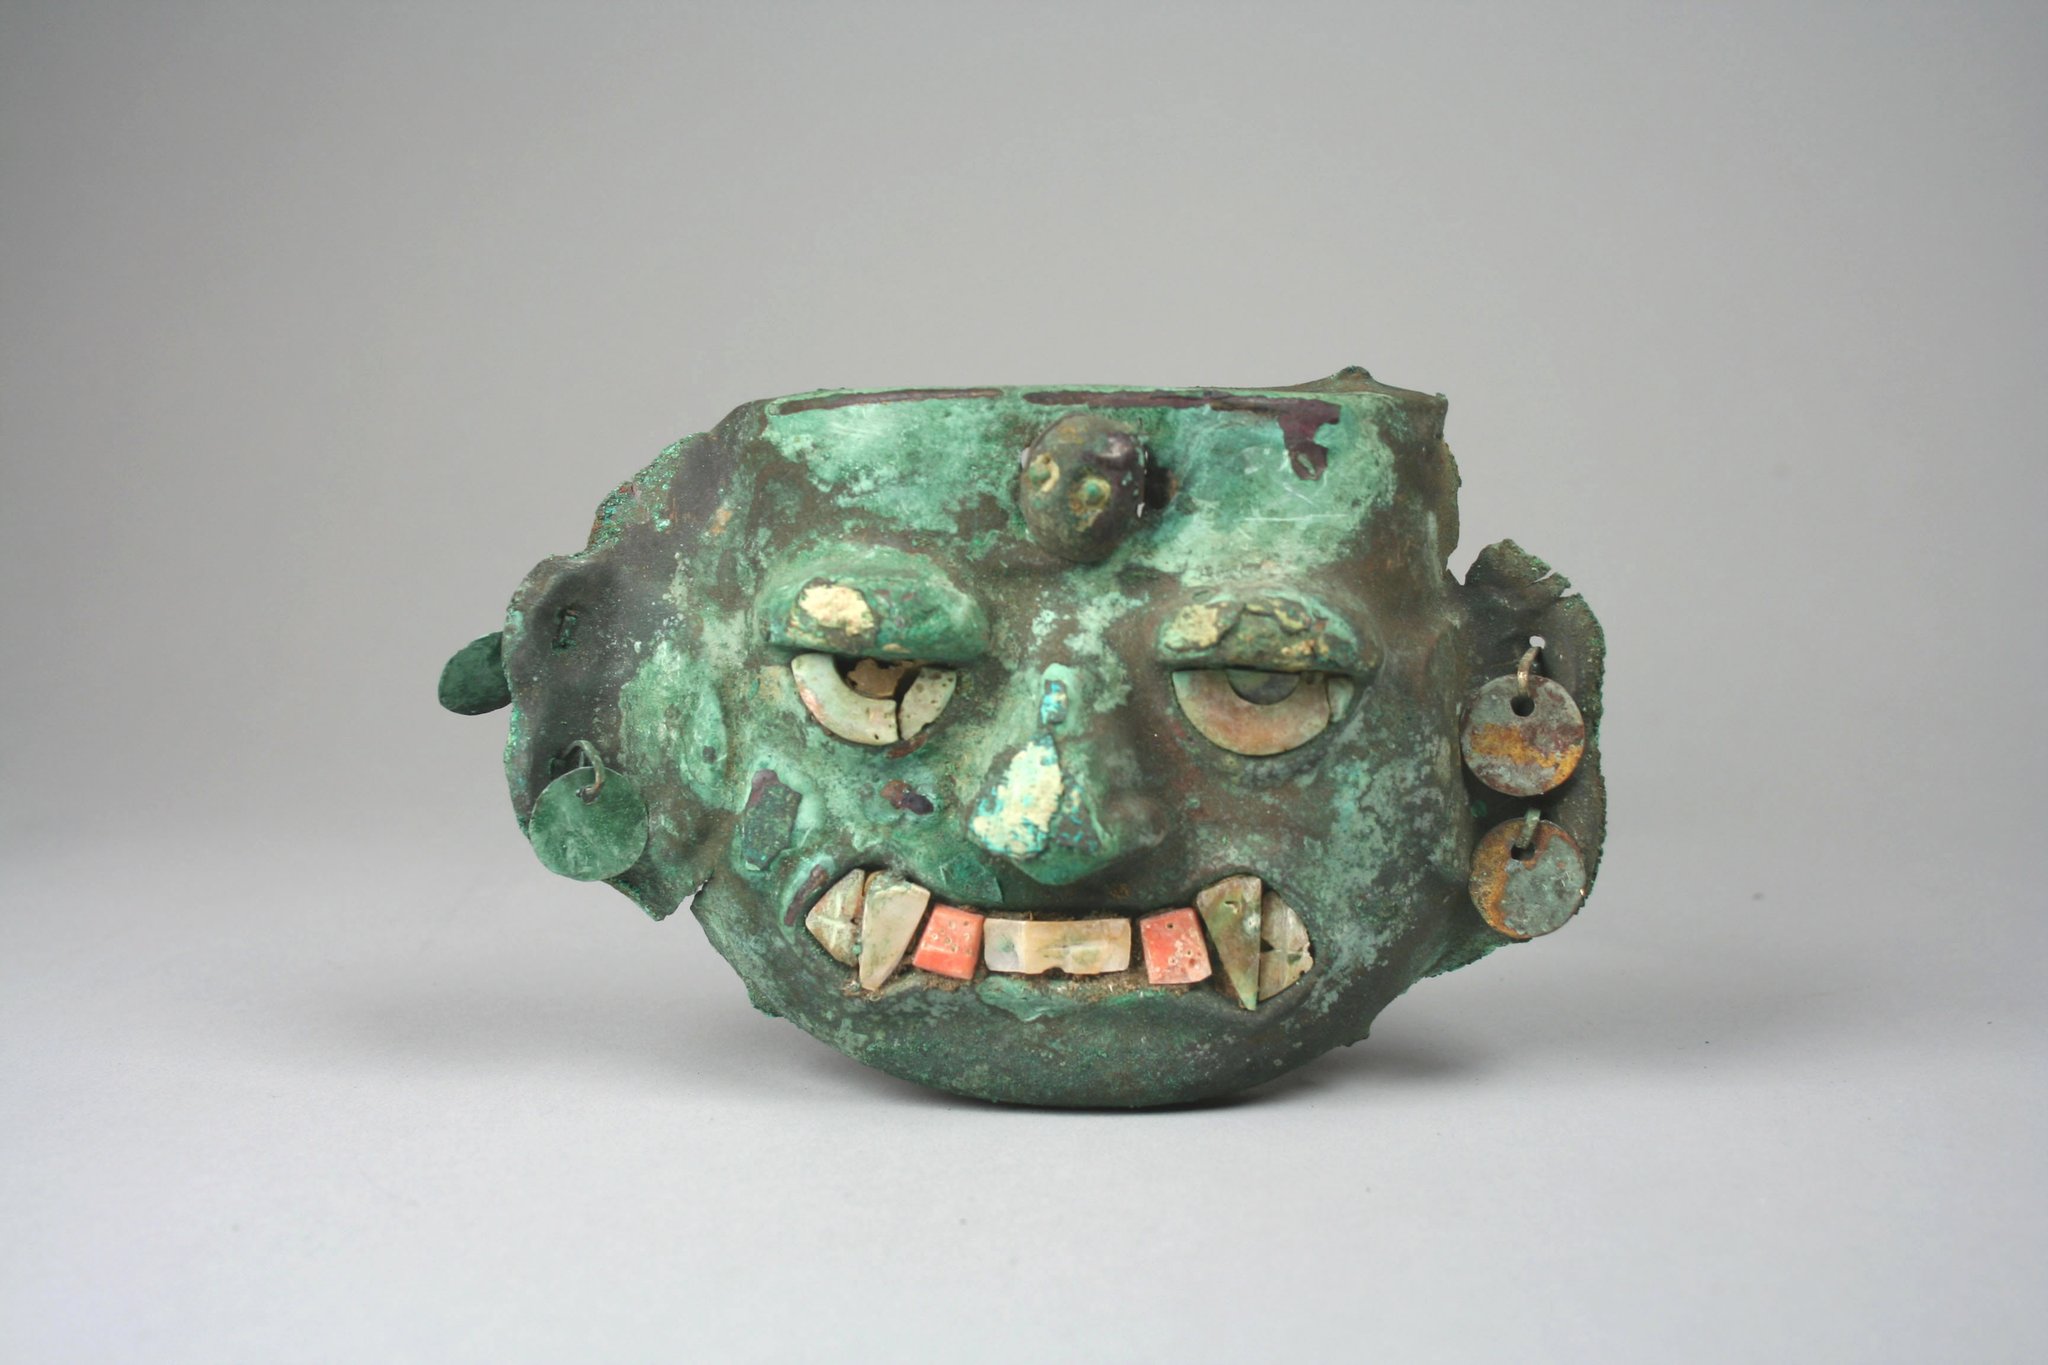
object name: ornament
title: Face Mask Ornament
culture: moche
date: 501-700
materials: shell, metal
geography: peru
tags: masks